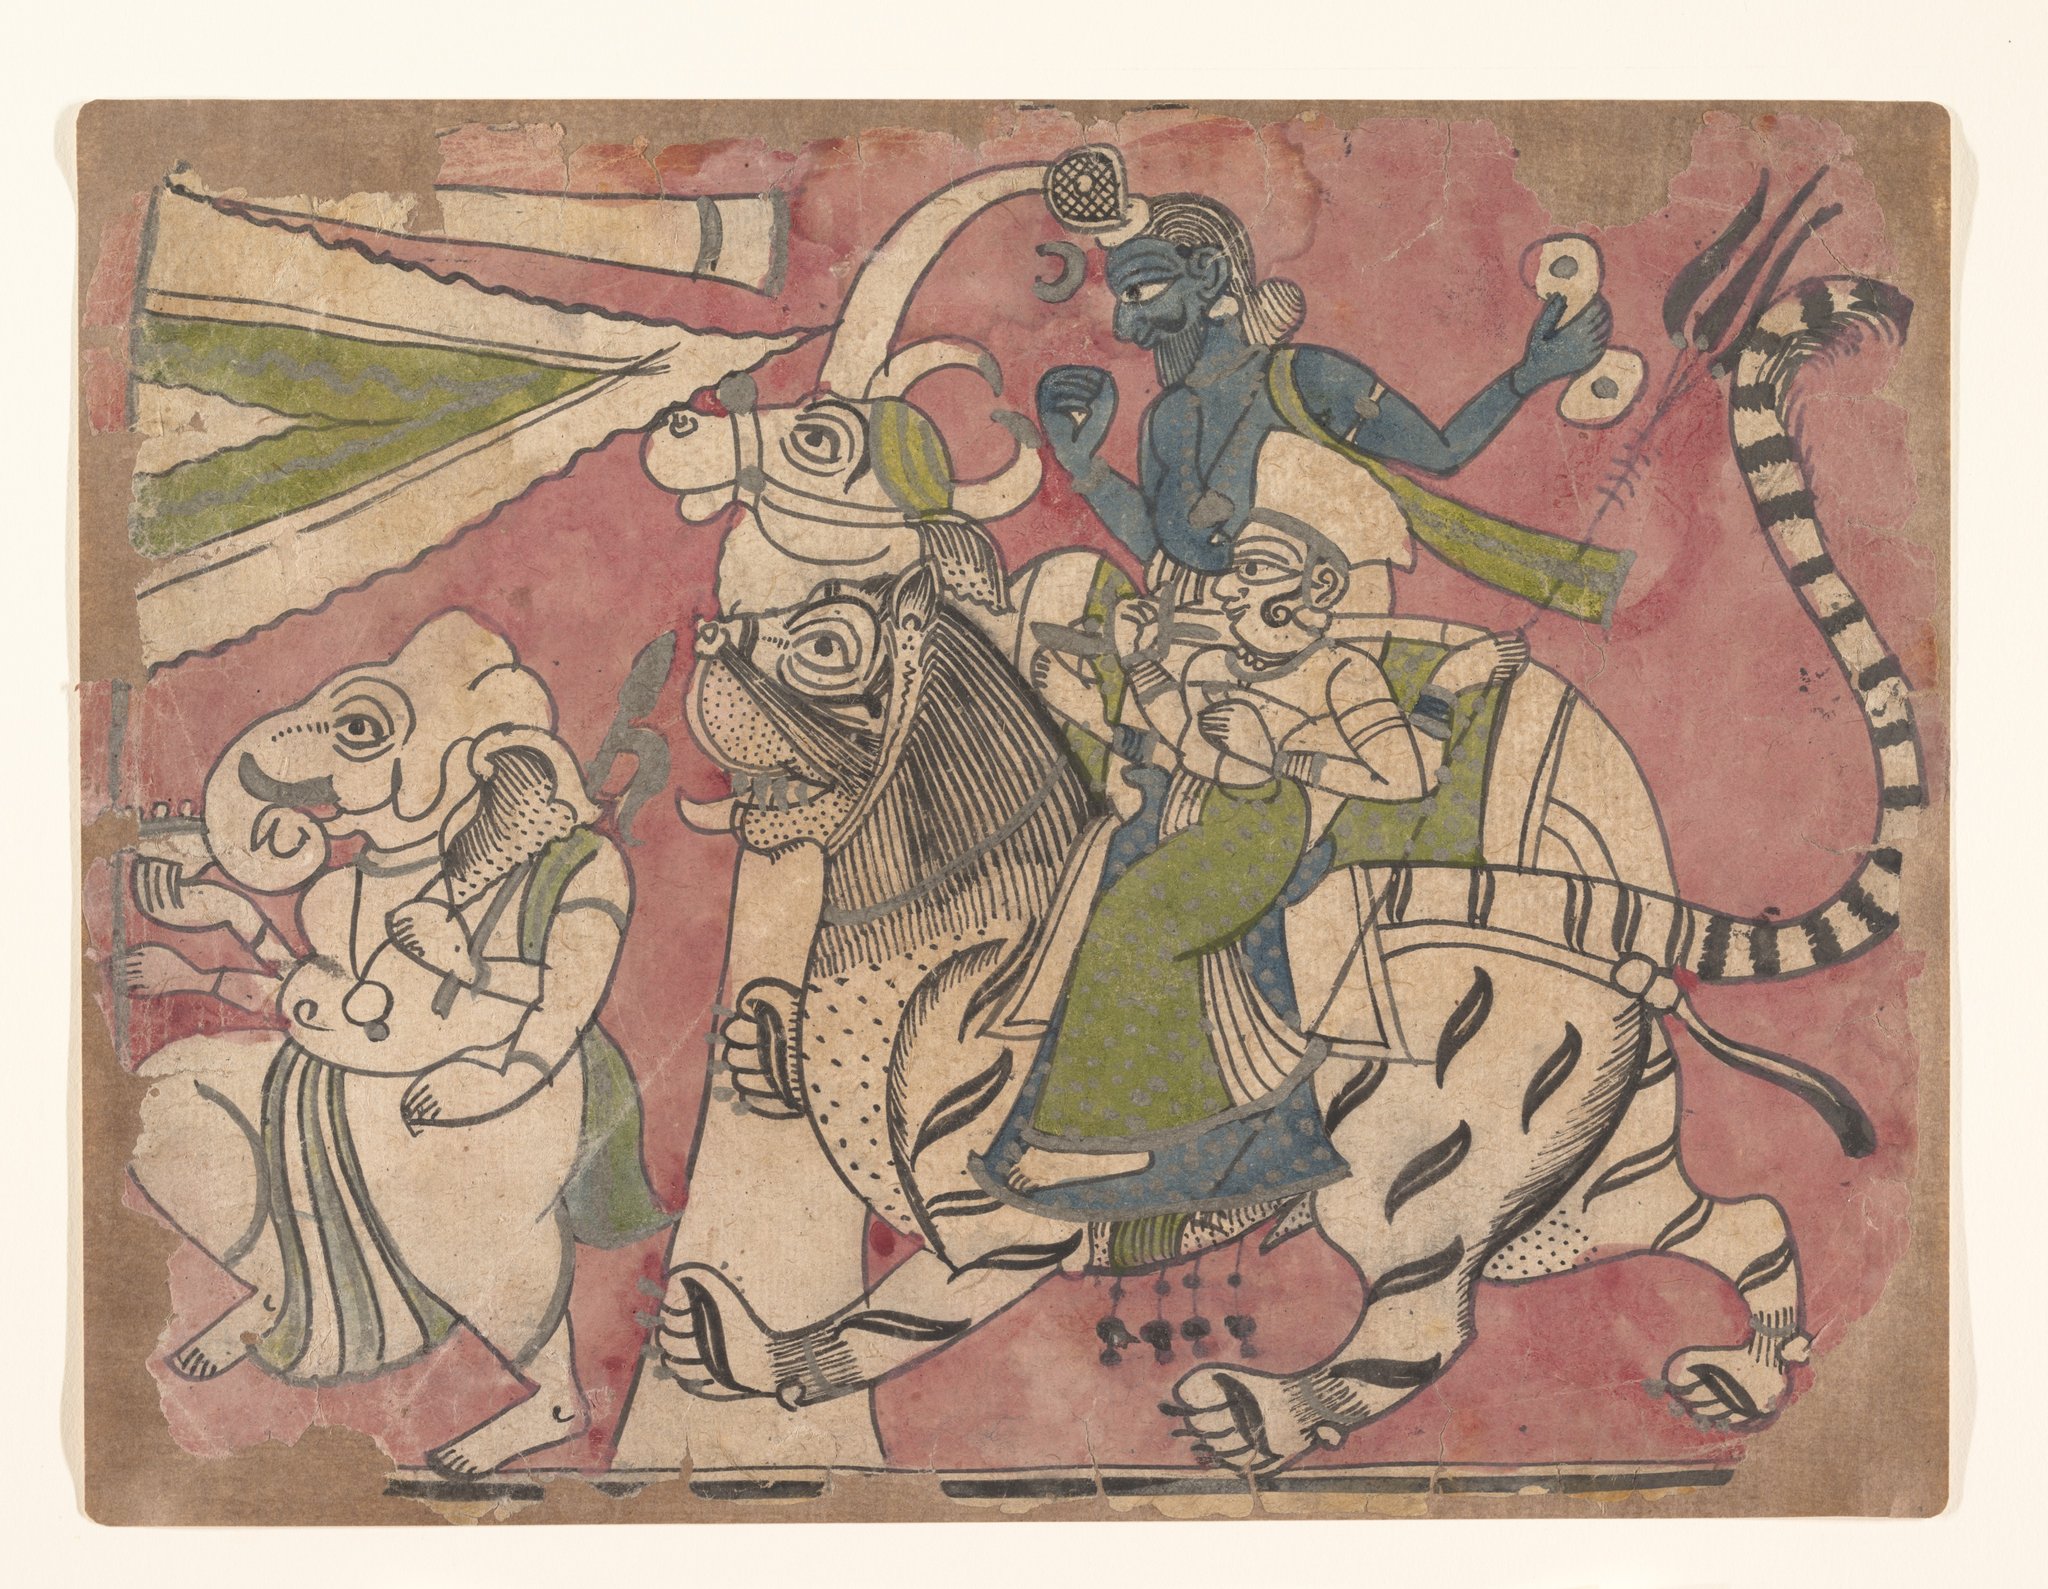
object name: painting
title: Ganesha Leads Shiva and Durga in Procession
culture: indian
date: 1701-1800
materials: ink, paper, watercolor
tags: bulls,elephants,tigers,durga,ganesha,shiva